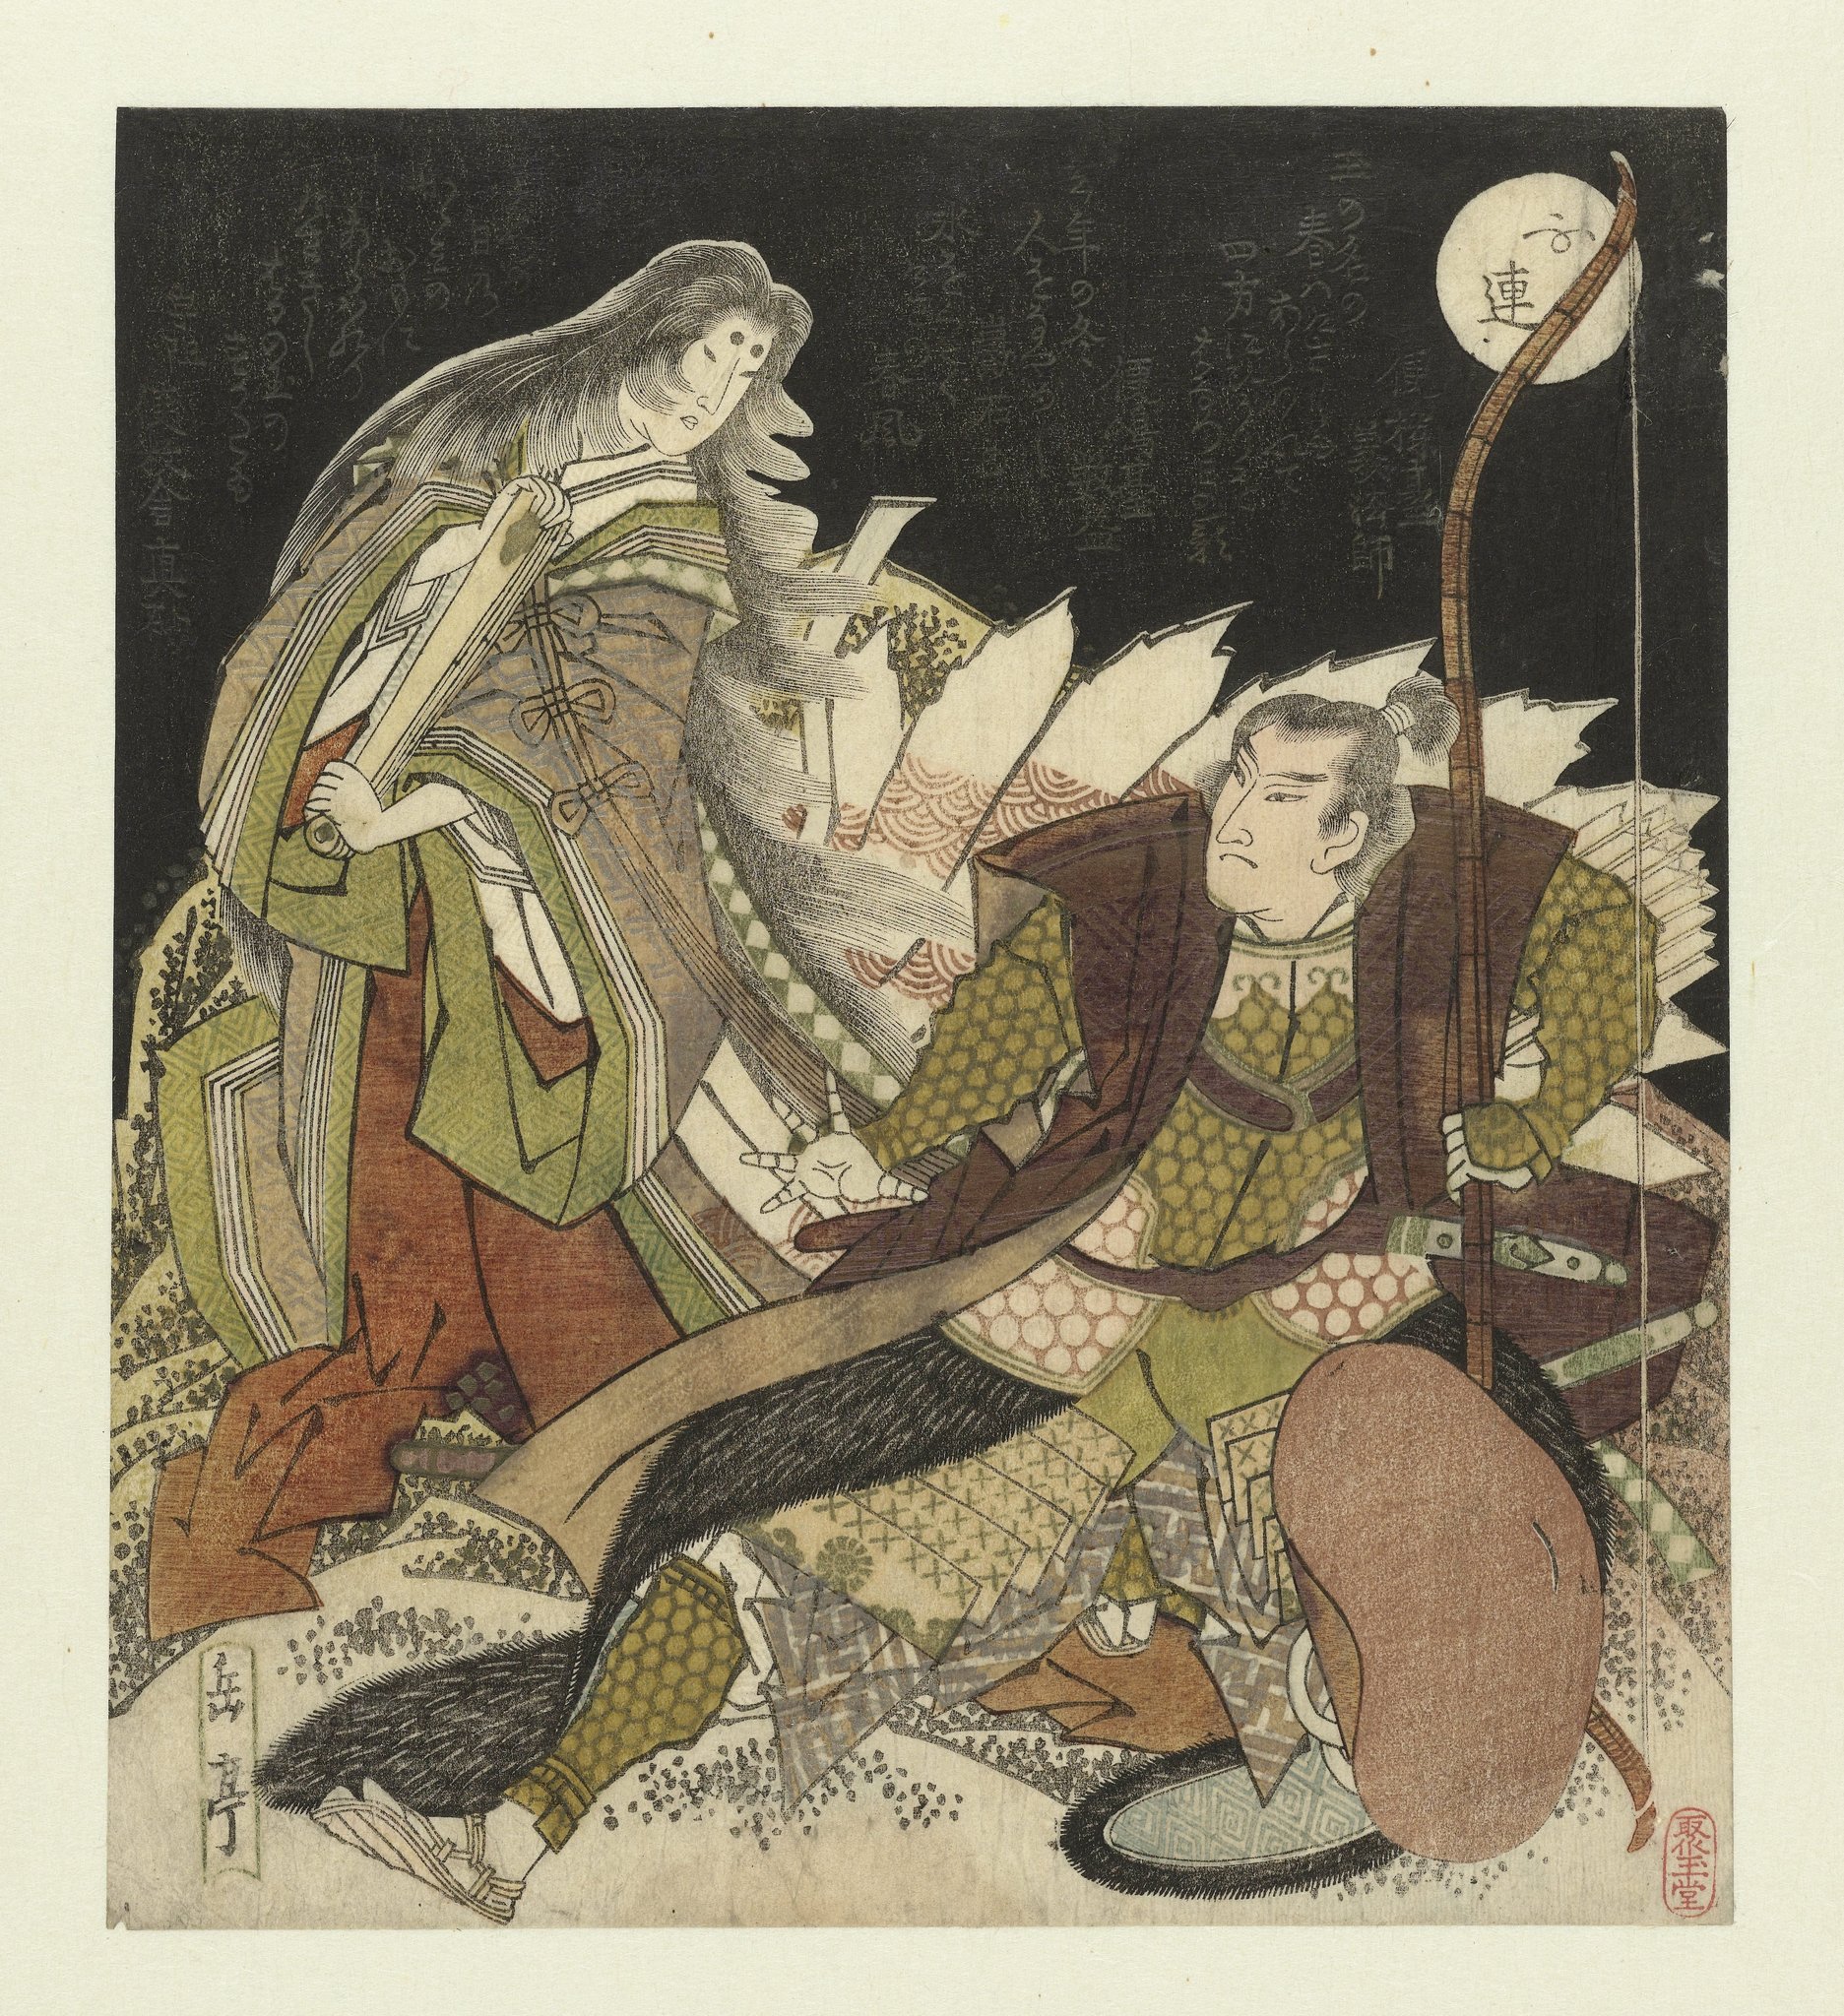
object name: surimono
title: Tamamo no Mae en Miura Kuranosuke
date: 1827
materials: paper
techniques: blind stamped, woodcut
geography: japan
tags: archer's weapons: bow and arrow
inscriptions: collector's mark, passe-partout, bottom left, printed: JABdH with a rooster., collector's mark, verso, stamped: Lugt 2228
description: Tegen een zwarte achtergrond is een krijger met boog, zittend op een rots afgebeeld. Ernaast een vrouw met lang haar. De vrouw is Tamamo no Mae ( het juwelen meisje). Zij is bezeten door een vos maar is zo mooi dat ze de geliefde werd van keizer Toba (1103-1156). Toen de keizer ziek werd, werd de schuld daarvan bij haar gelegd, waarna ze het paleis ontvluchtte. Uiteindelijk werd ze door een jager neergeschoten waarna ze in een rots veranderde. Met drie gedichten.